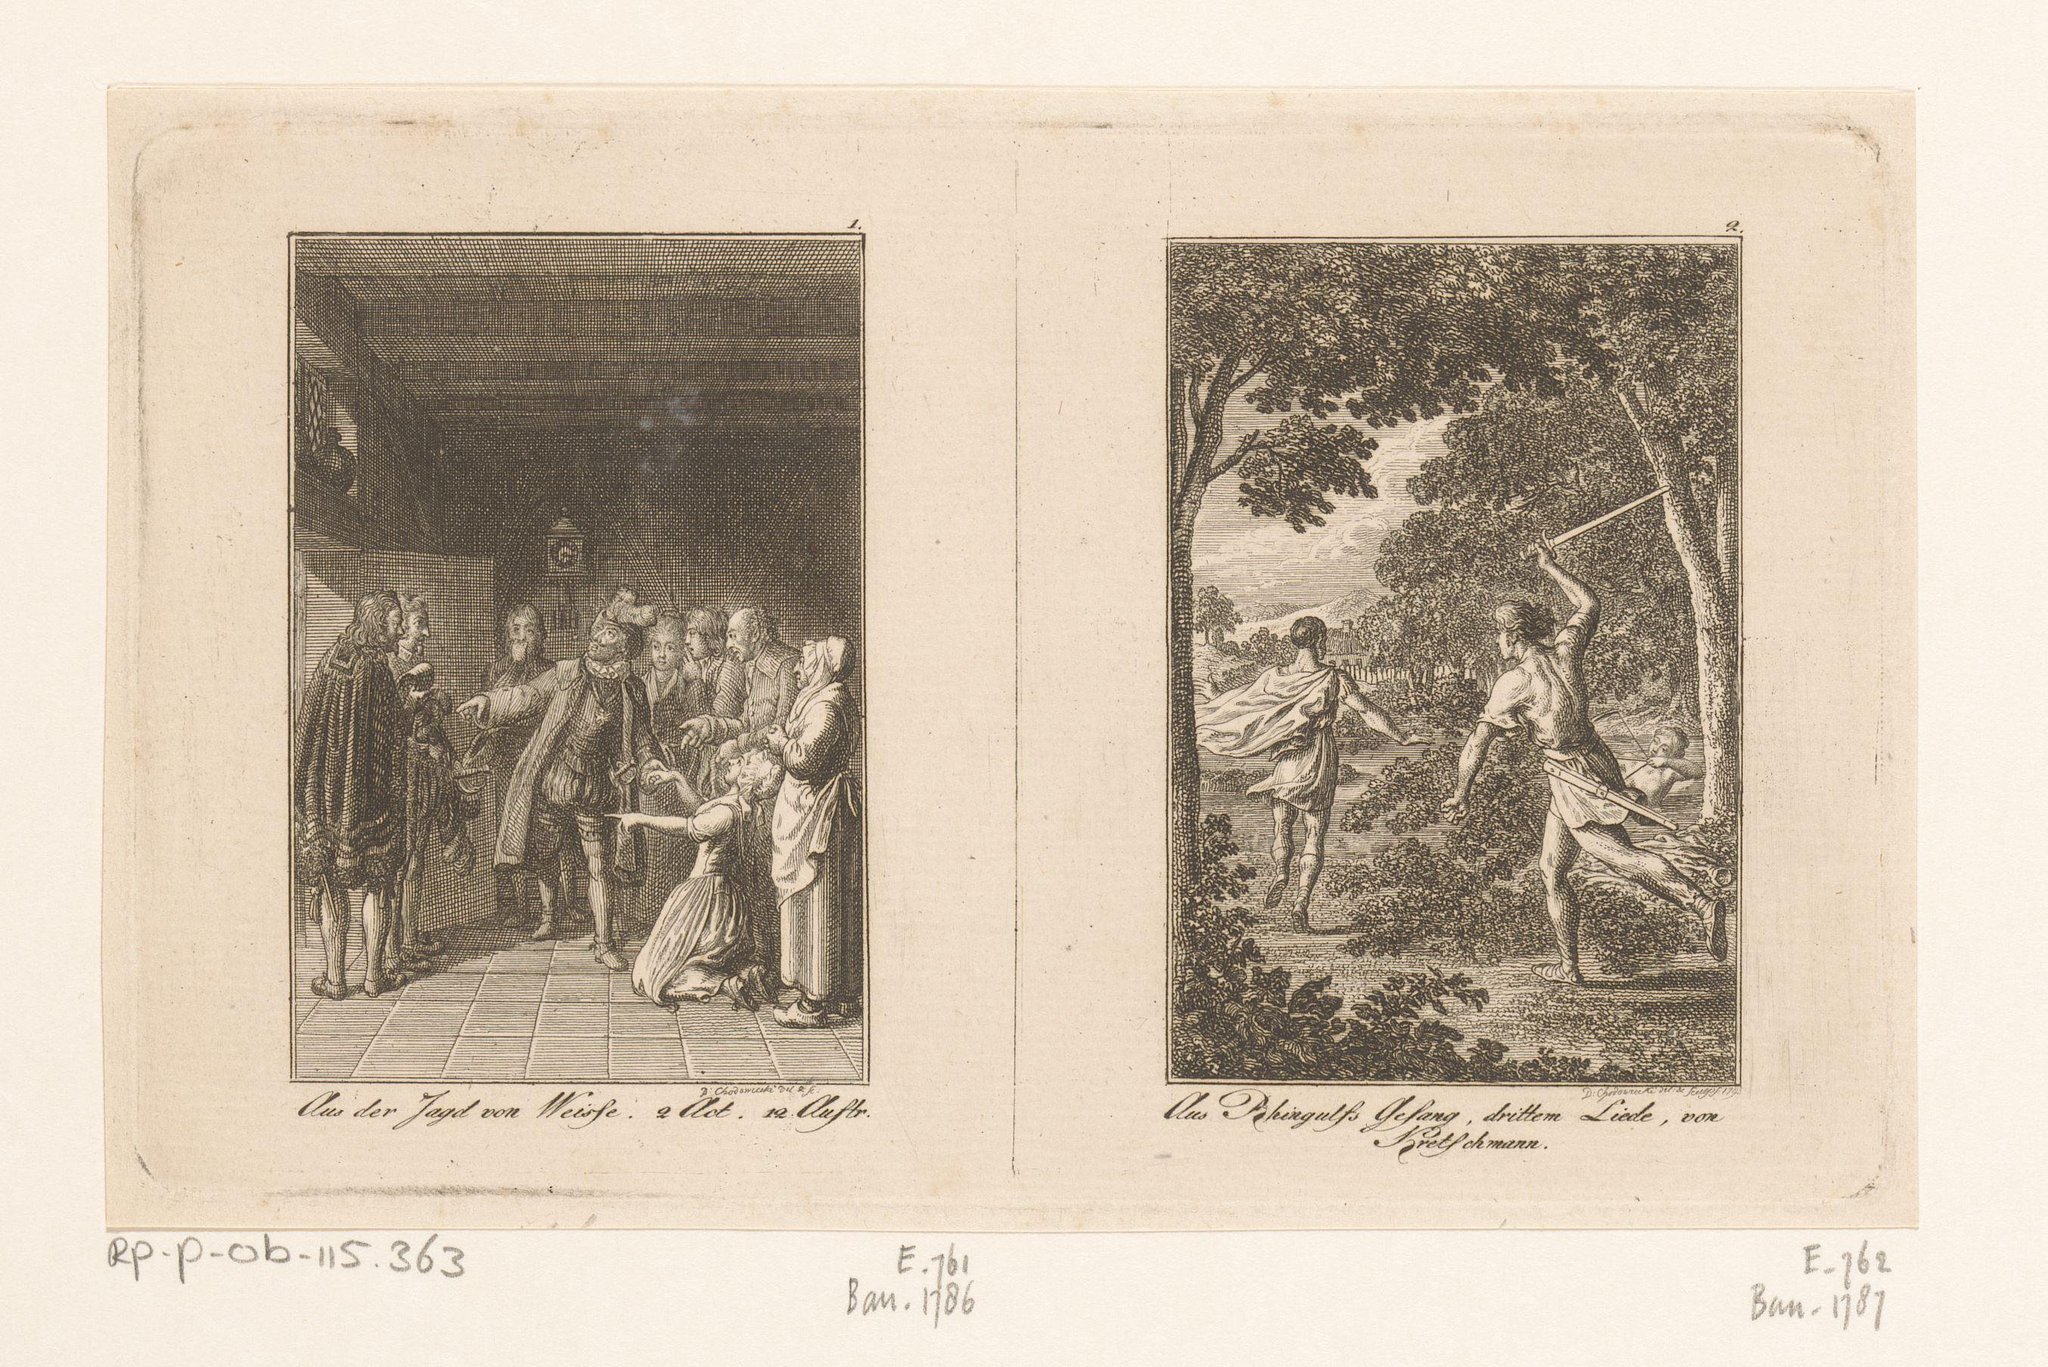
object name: print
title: Twee voorstellingen uit de verhalen van Wilhelm Gottlieb Becker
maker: daniel nikolaus chodowiecki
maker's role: draughtsman, print maker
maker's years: 1726-1801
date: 1795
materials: paper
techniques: etching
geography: berlin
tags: hacking and thrusting weapons: sword, archer's weapons: bow, flight, running away; pursuing, kneeling figure, index finger forwards, pointing, indicating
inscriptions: collector's mark: Lugt 2228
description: Prent gebruikt voor: Becker, Wilhelm Gottlieb. Taschenbuch und Almanach zum geselligen Vergnügen von W. G. Becker für 1796. Leipzig: Voss und Companie, [1795].